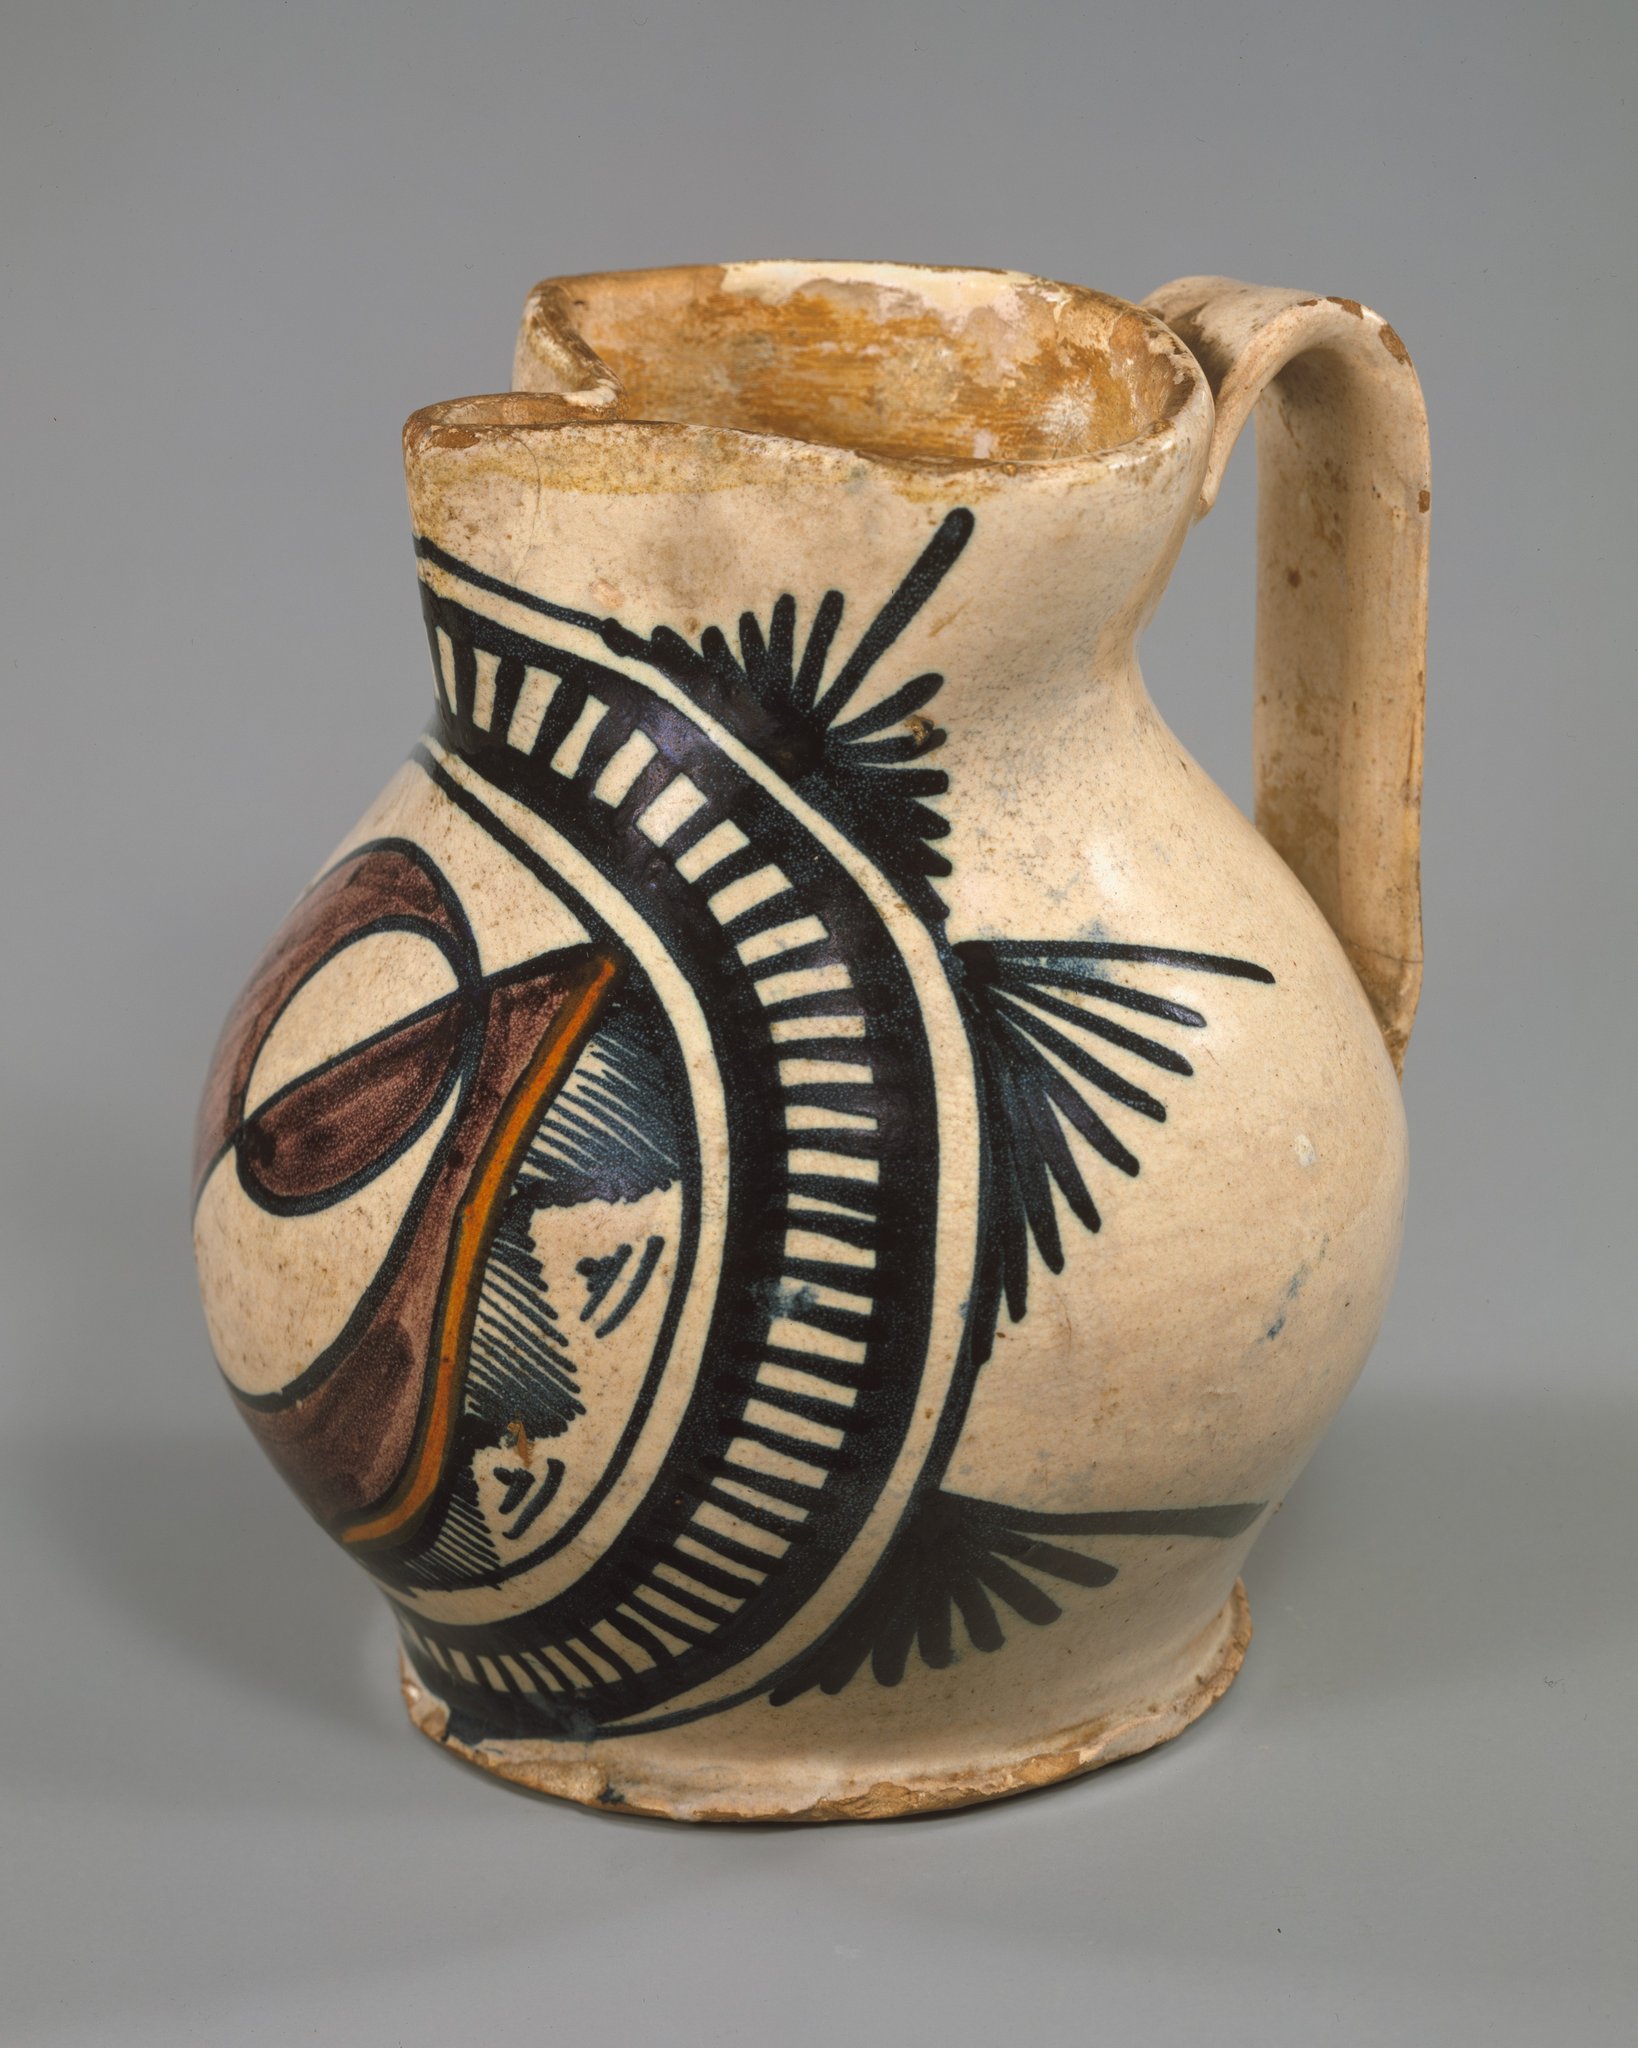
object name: jug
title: Armorial jug (boccale)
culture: italian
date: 1470-1500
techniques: maiolica, glazing